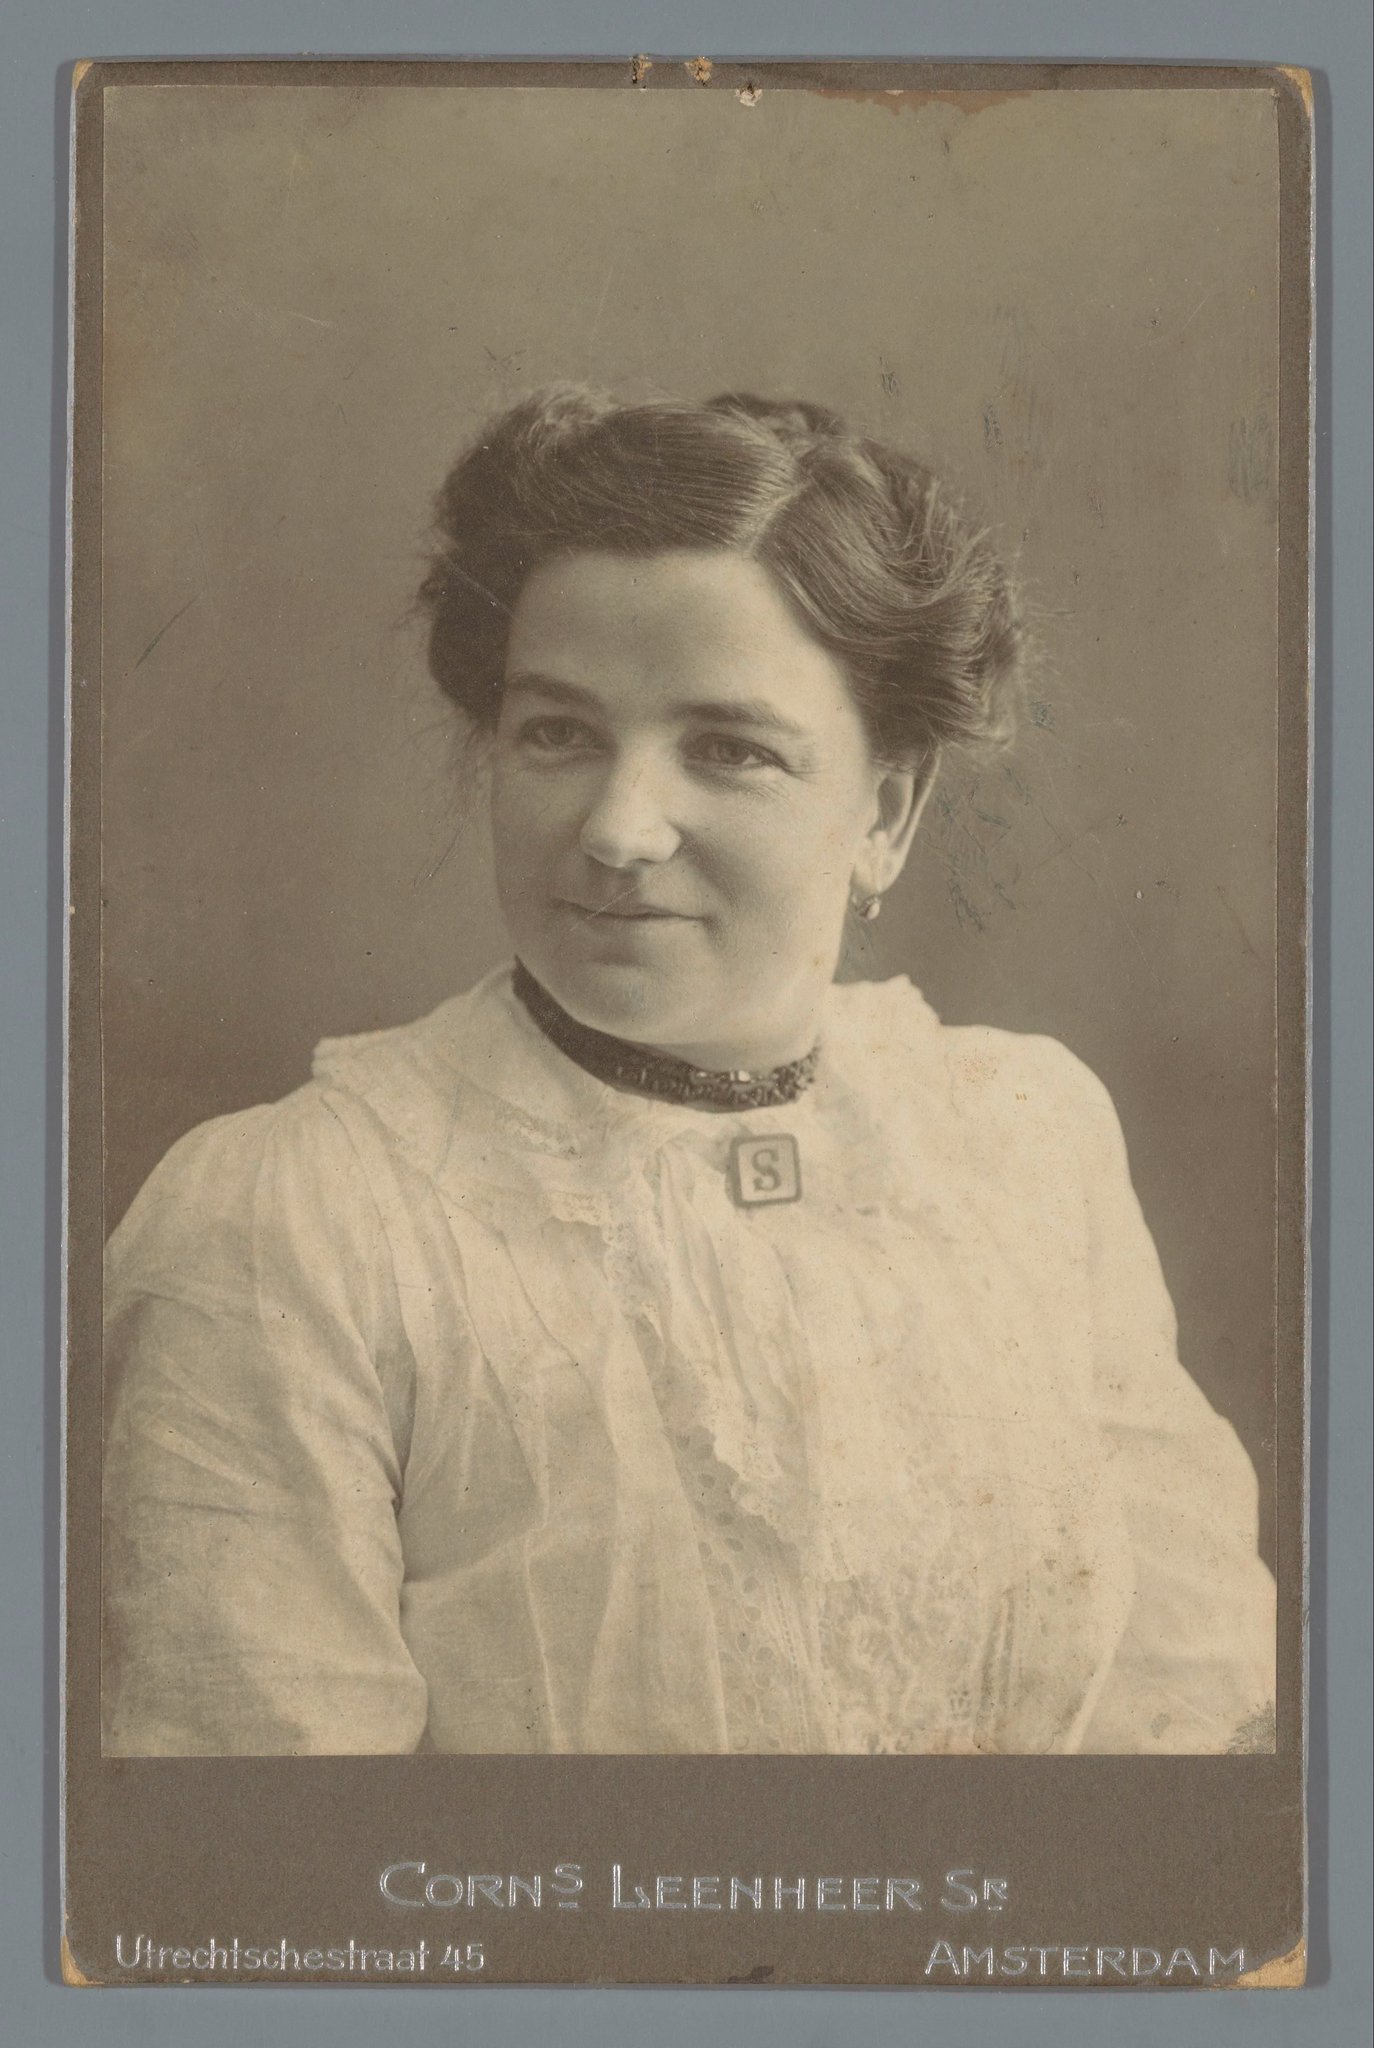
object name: cabinet photograph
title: Portret van een onbekende vrouw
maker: cornelis leenheer sr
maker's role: fotograaf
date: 1910-1942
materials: cardboard, photographic support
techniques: gelatin silver print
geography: amsterdam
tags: adult woman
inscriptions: name: ‘Corns Leenheer Sr Utrechtschestraat 45 Amsterdam’